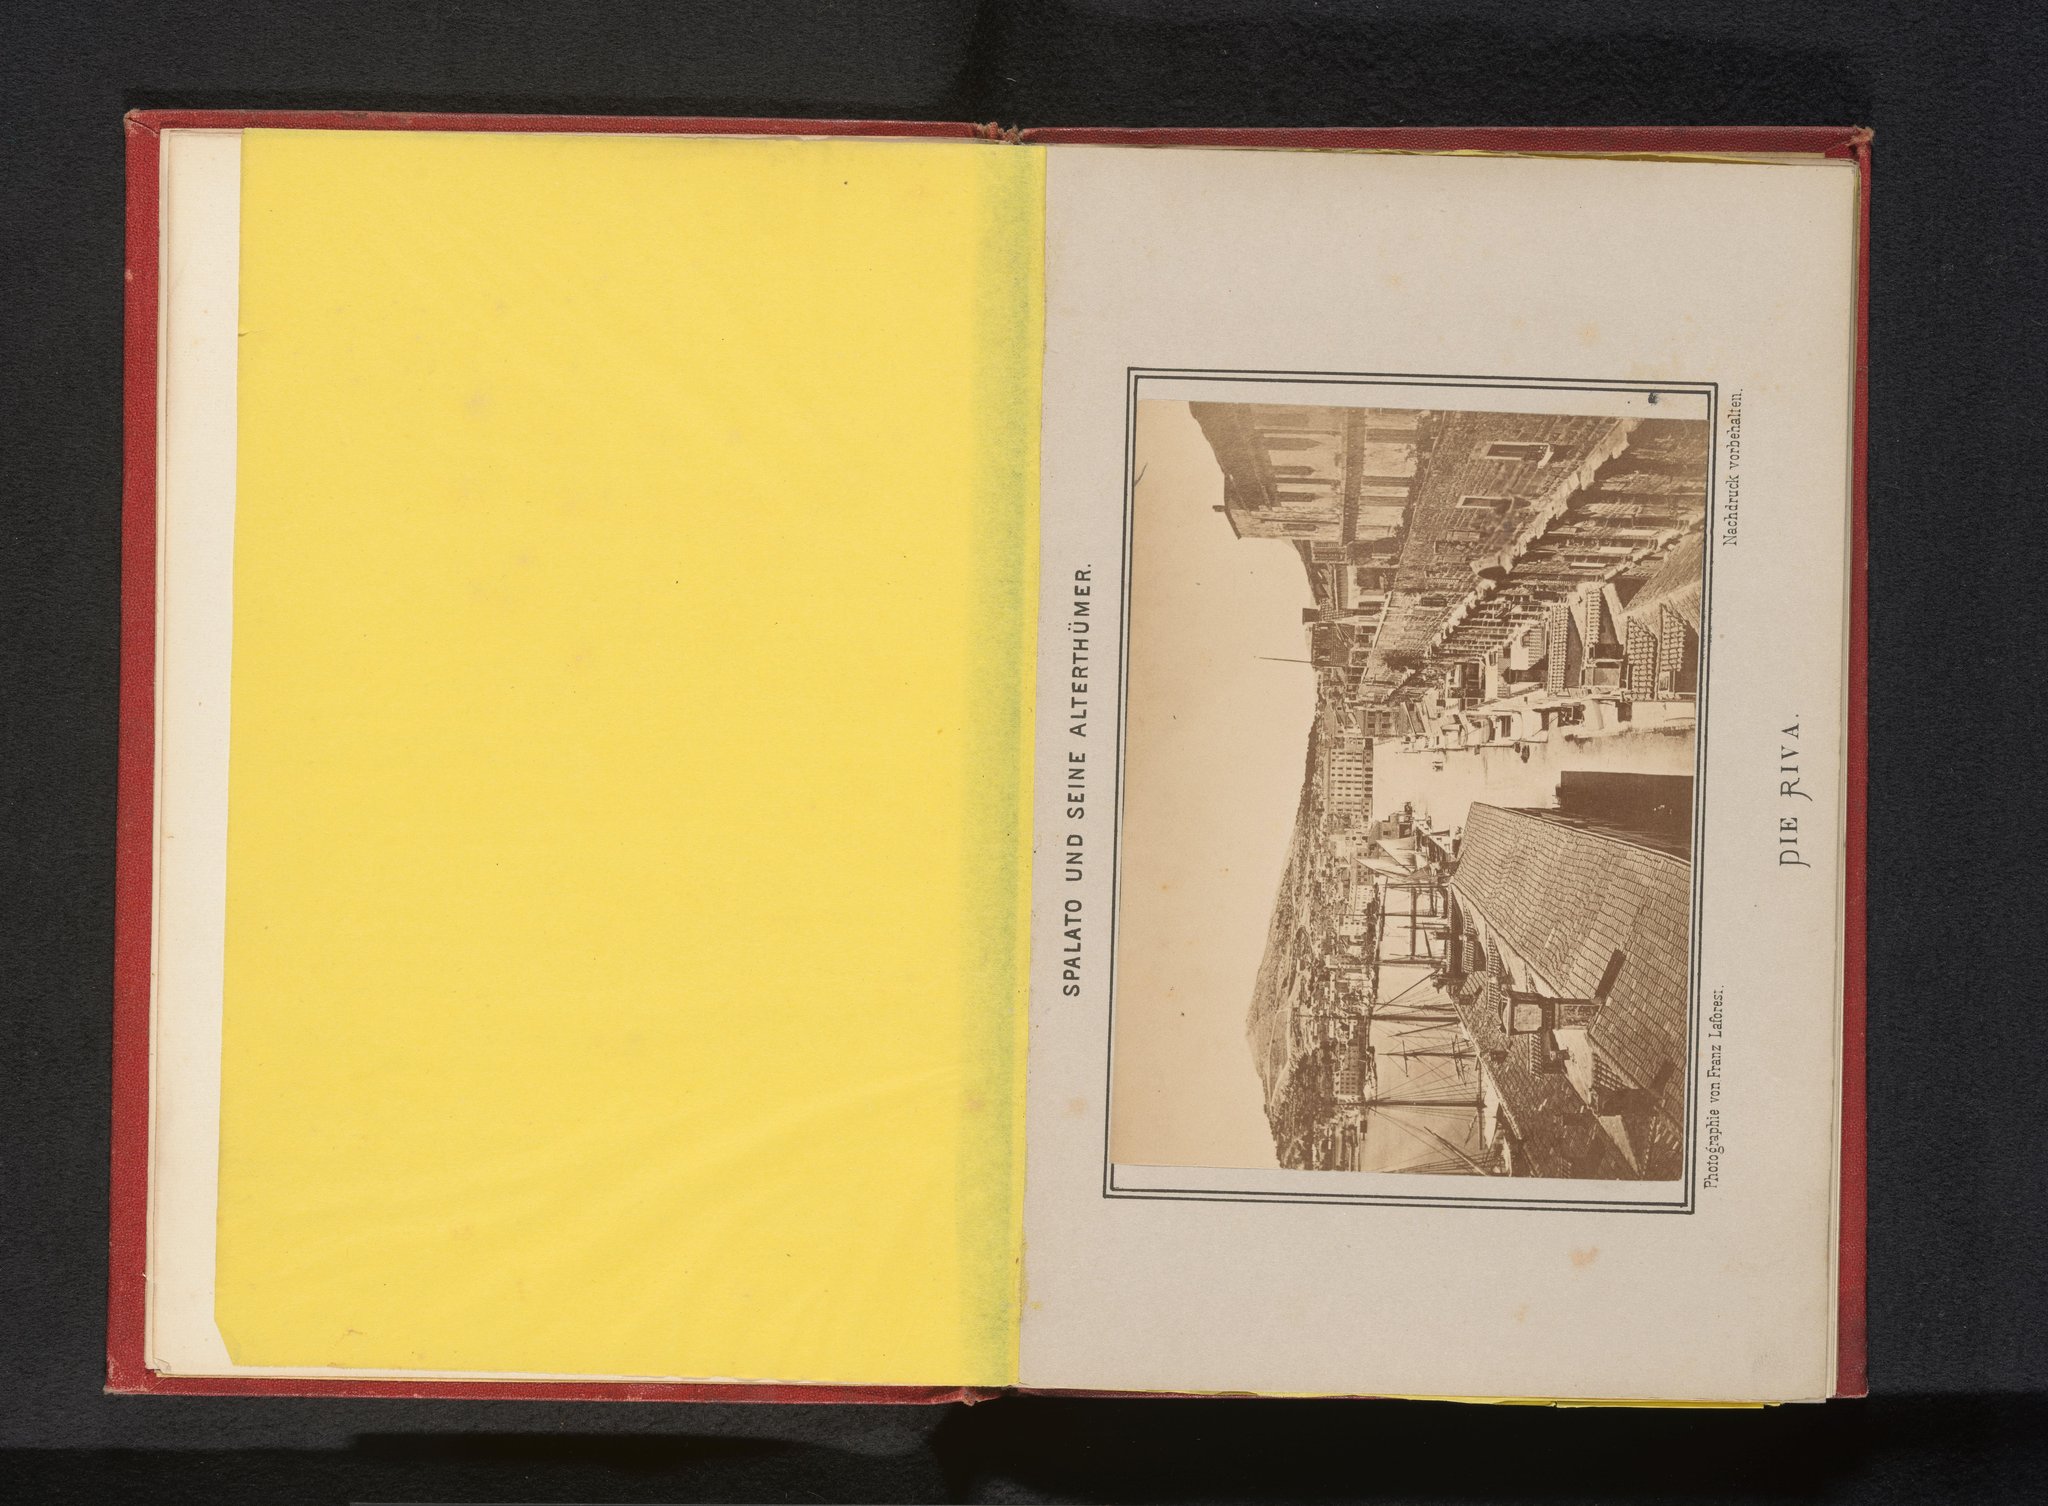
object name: photograph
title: Die Riva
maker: franz thiard de laforest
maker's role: fotograaf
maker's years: 1838-1911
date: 1868-1878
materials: photographic support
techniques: albumen print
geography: split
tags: pier, quay, wharf